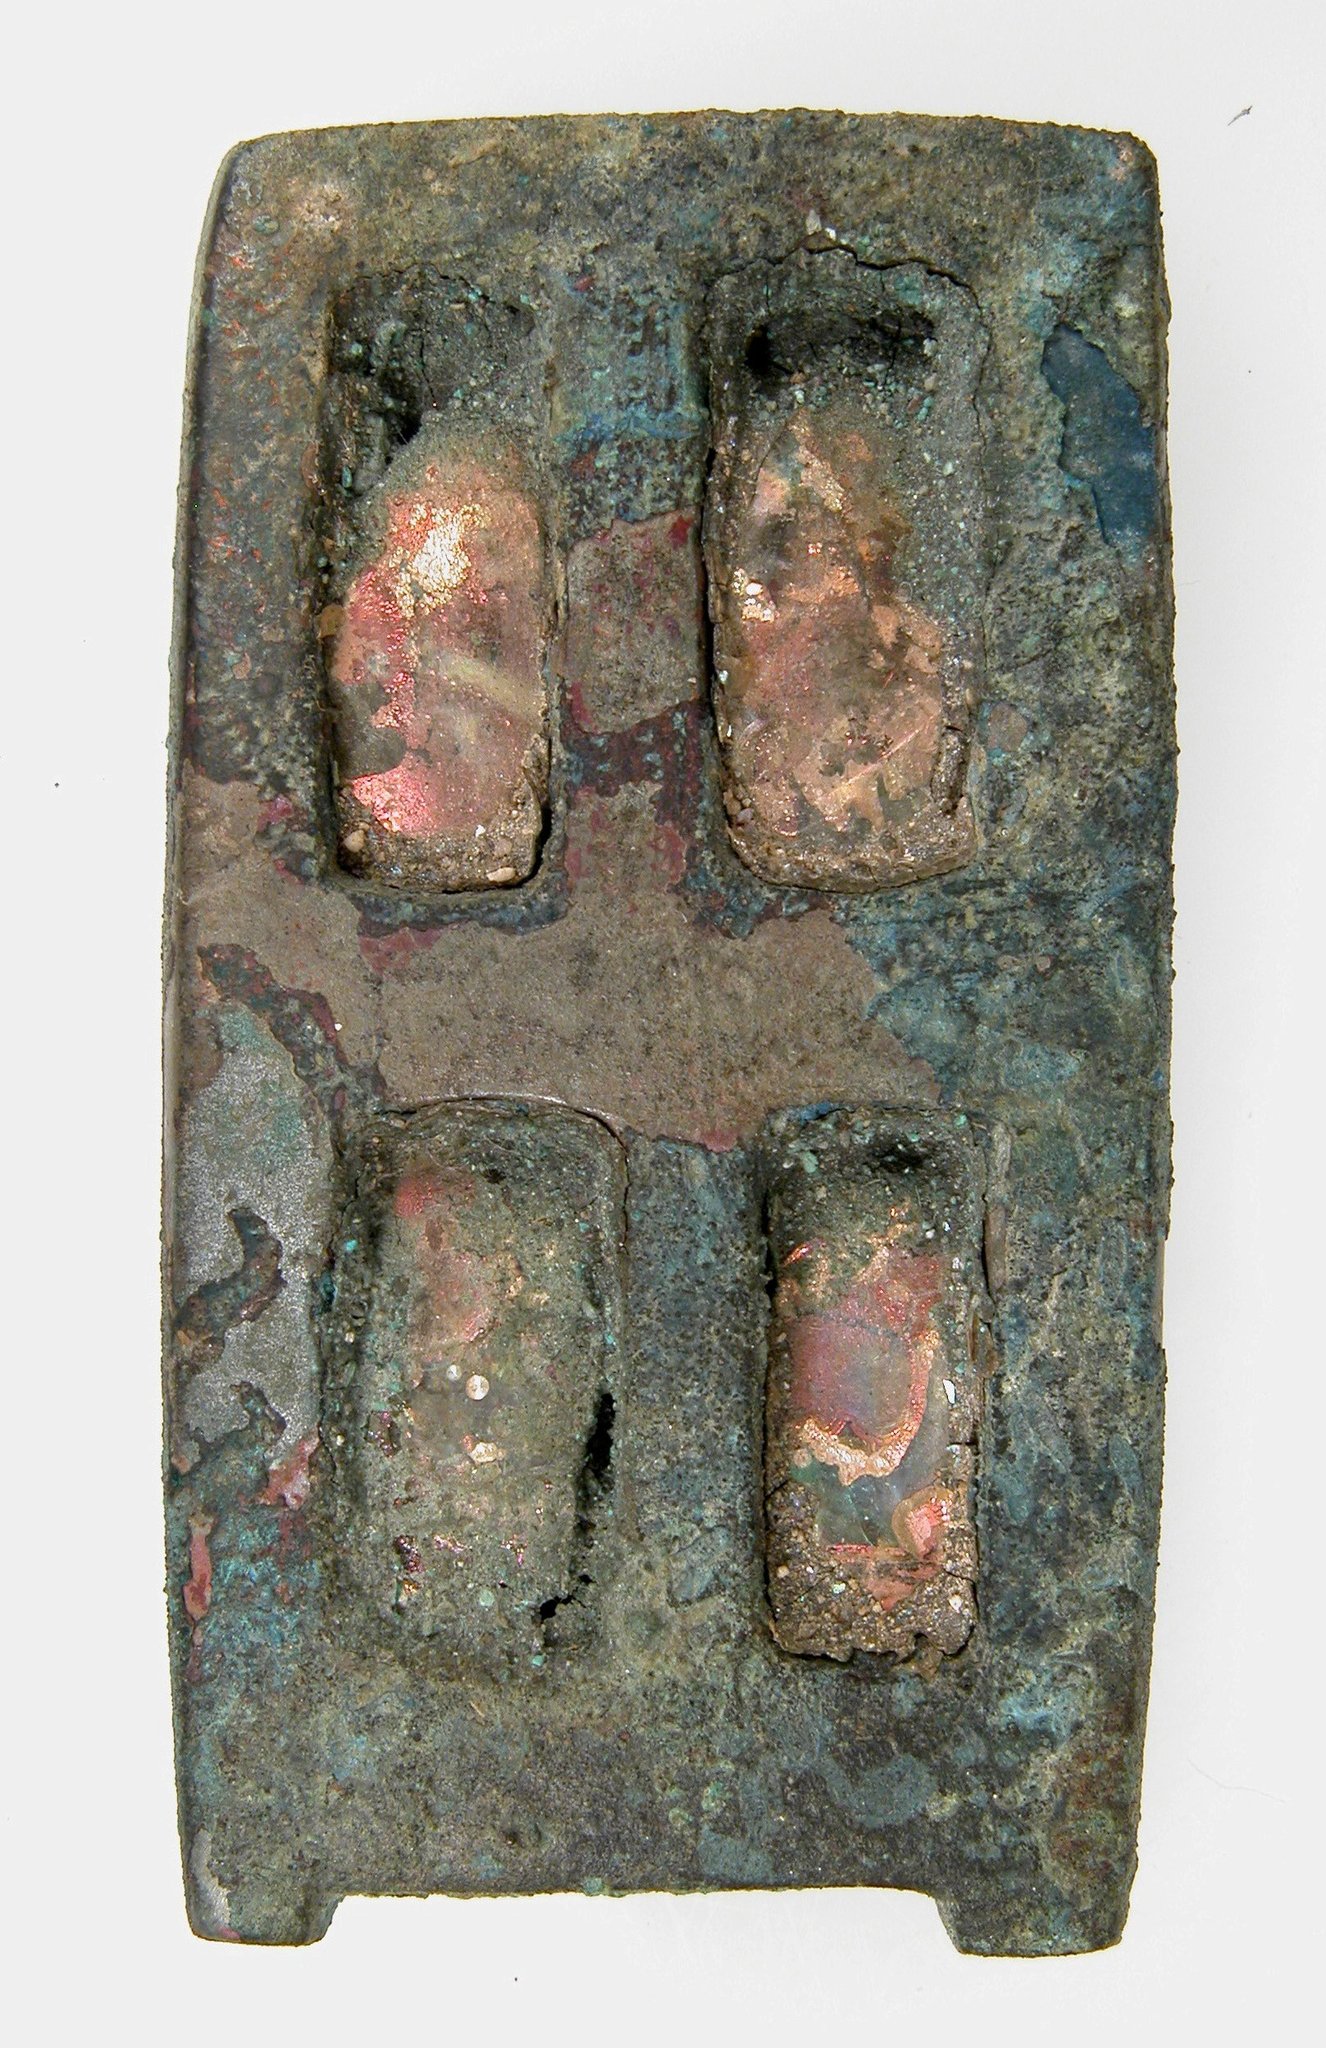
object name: plaque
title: Rectangular Plaque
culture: frankish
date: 534-566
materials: copper alloy, glass, gold foil, paste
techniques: inlay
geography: france